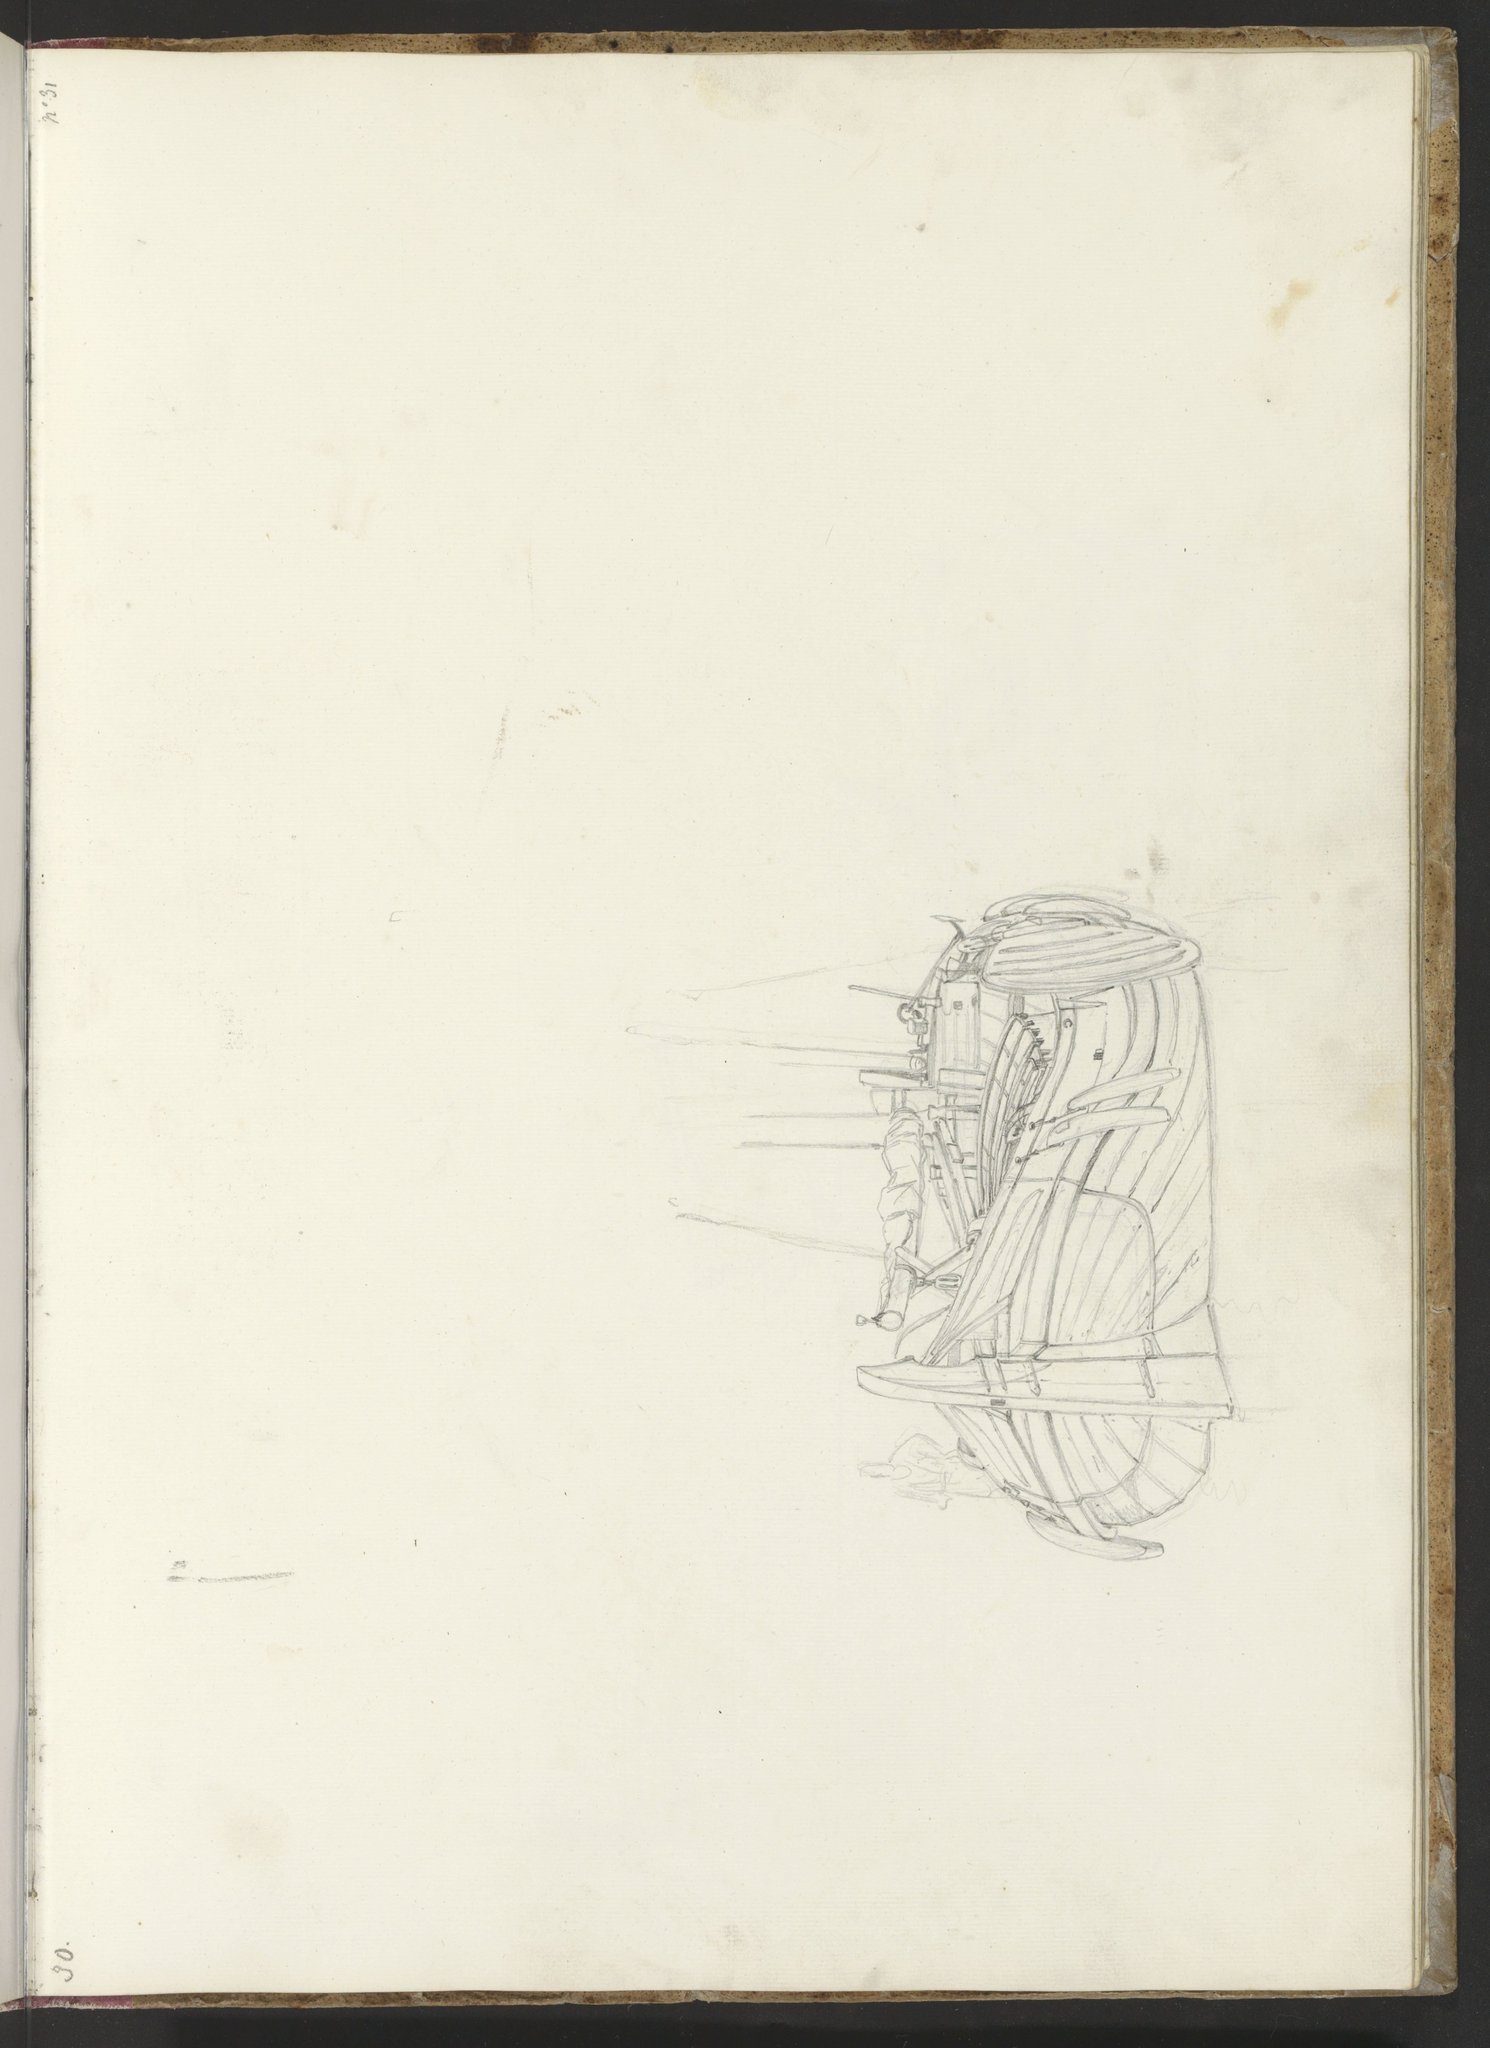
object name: sketchbook leaf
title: Zeilboot en een staande figuur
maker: johannes christiaan schotel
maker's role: draughtsman, painter, print maker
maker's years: 1787-1838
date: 1797-1838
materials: paper, pencil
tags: standing figure, sailing-ship, sailing-boat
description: Blad 30 recto uit een schetsboek met 65 bladen.